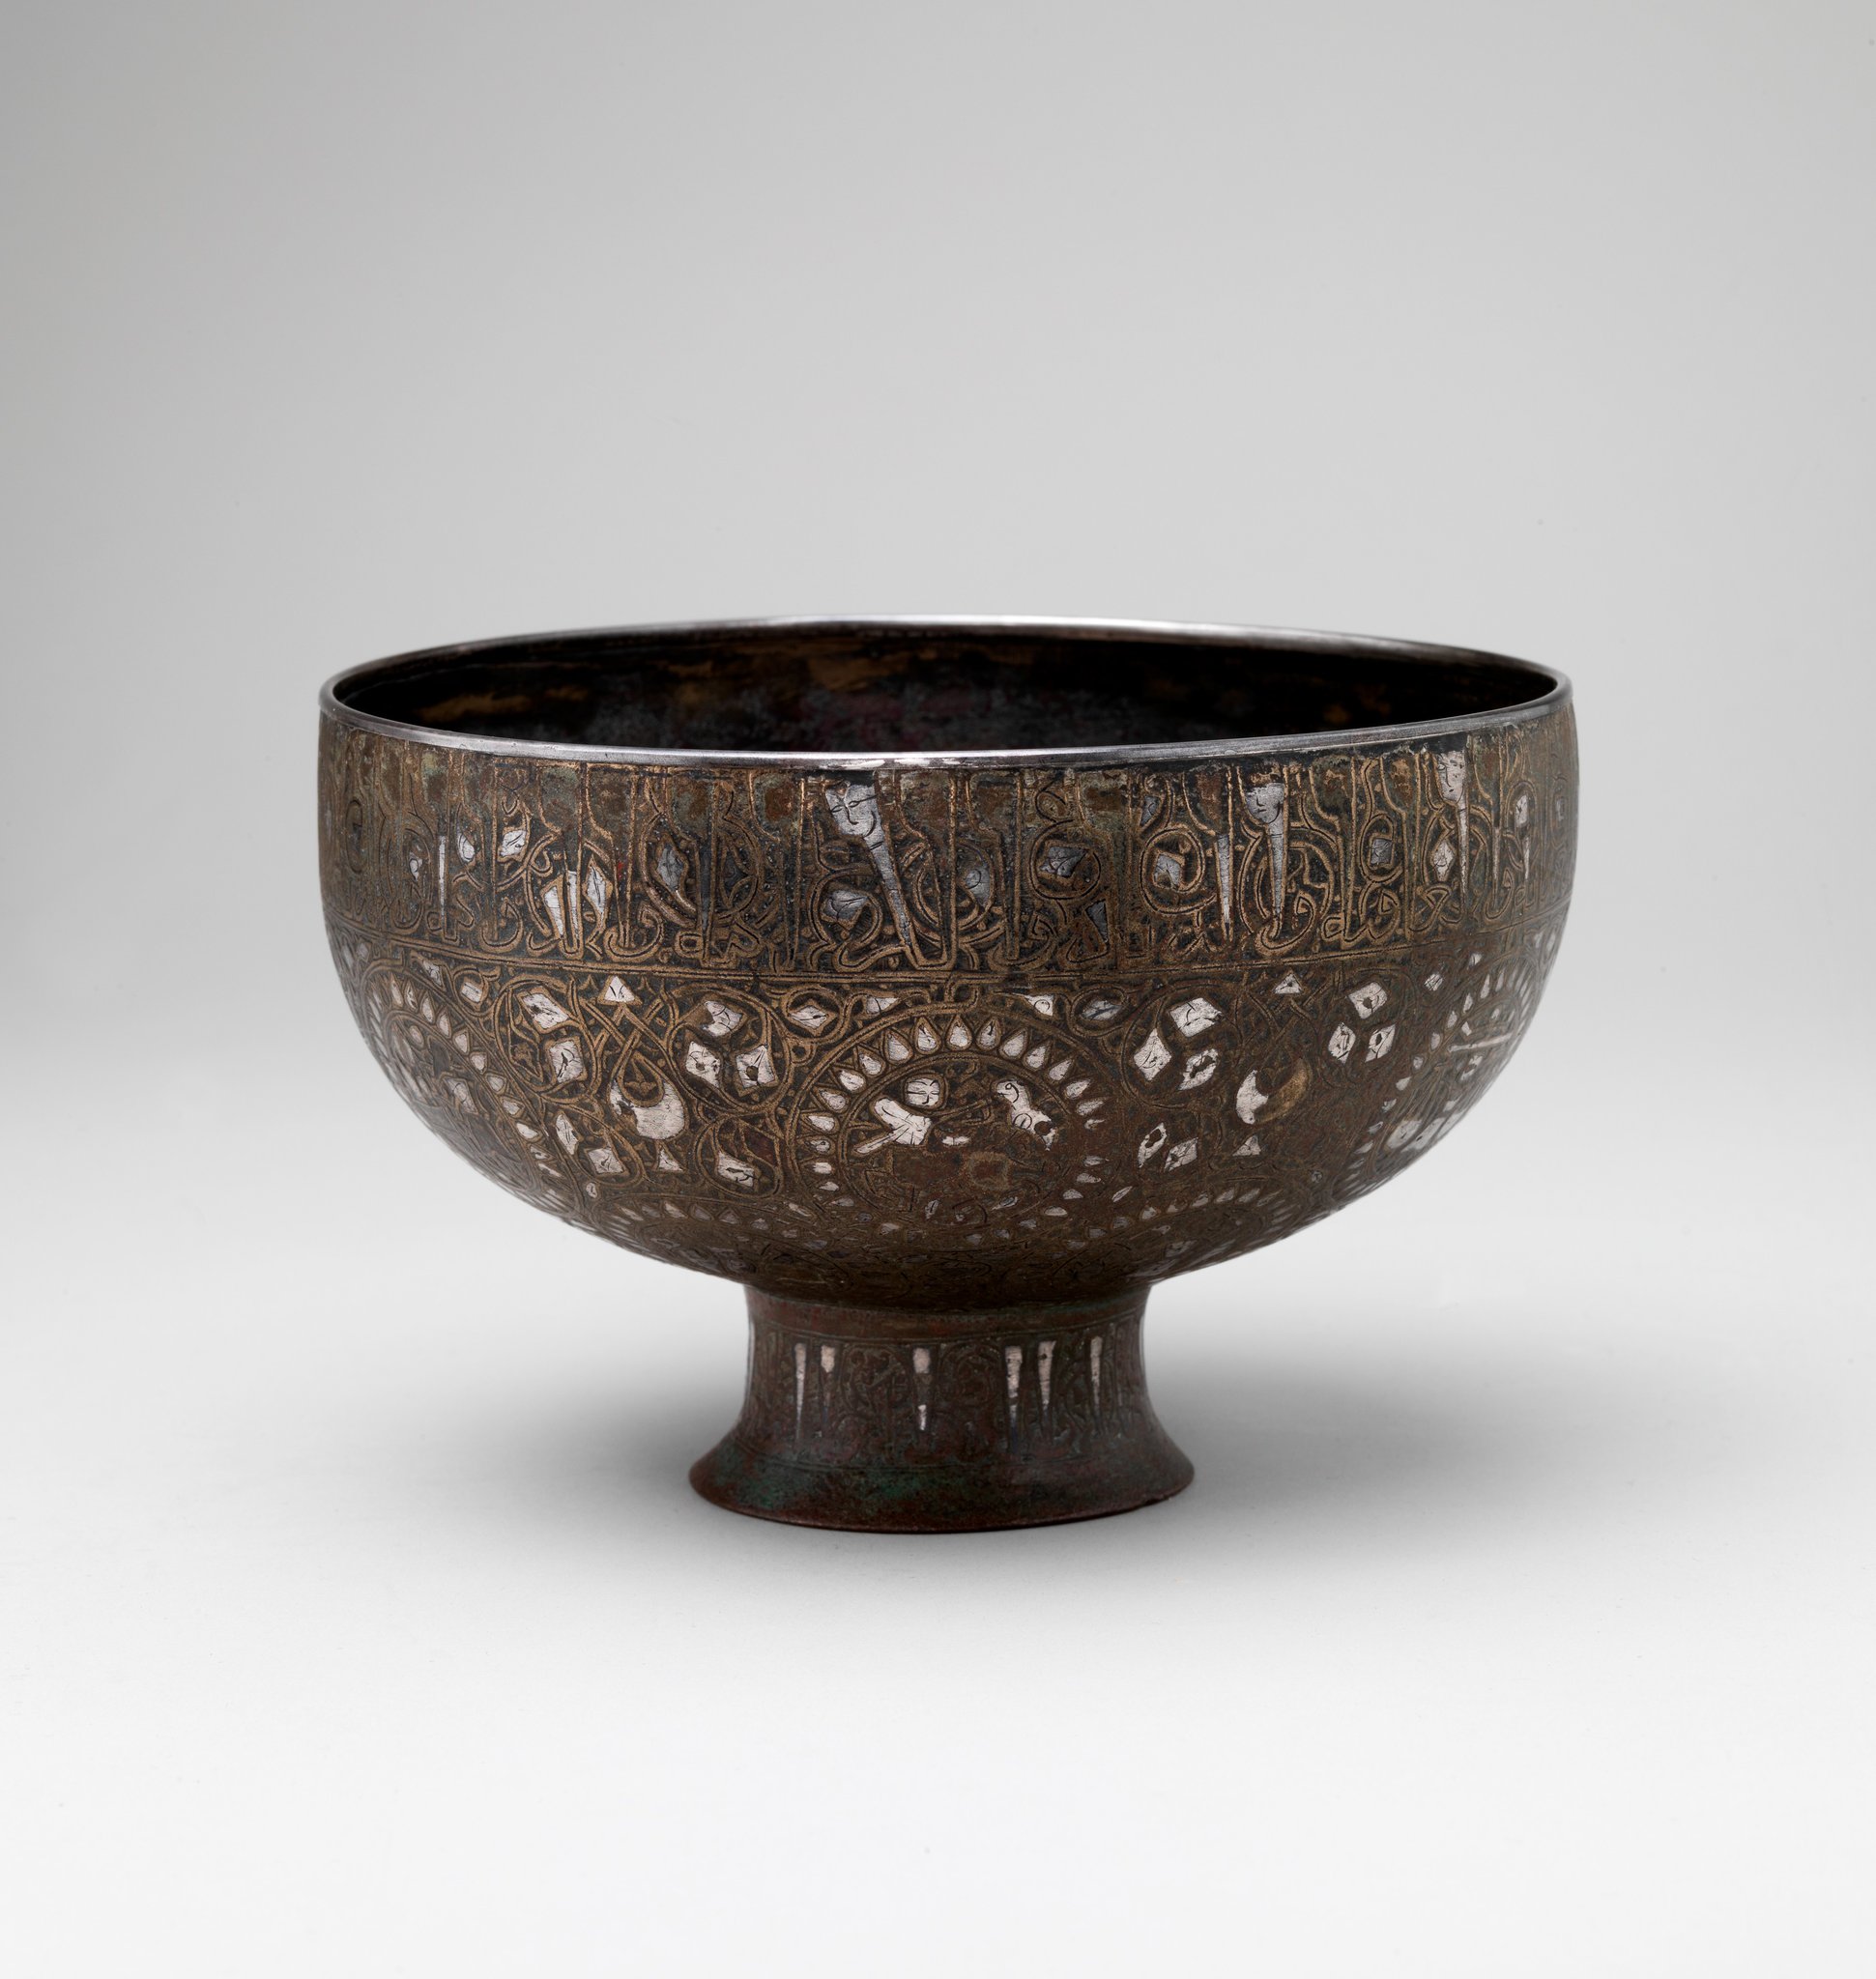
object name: bowl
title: Footed Bowl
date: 1201-1233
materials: bronze, silver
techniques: inlay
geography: iran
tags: zodiac